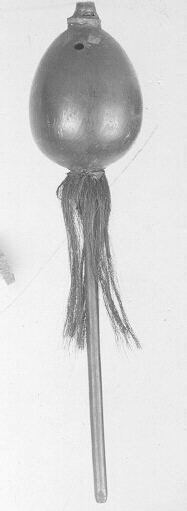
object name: rattle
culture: indian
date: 1867-1900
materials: wood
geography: india